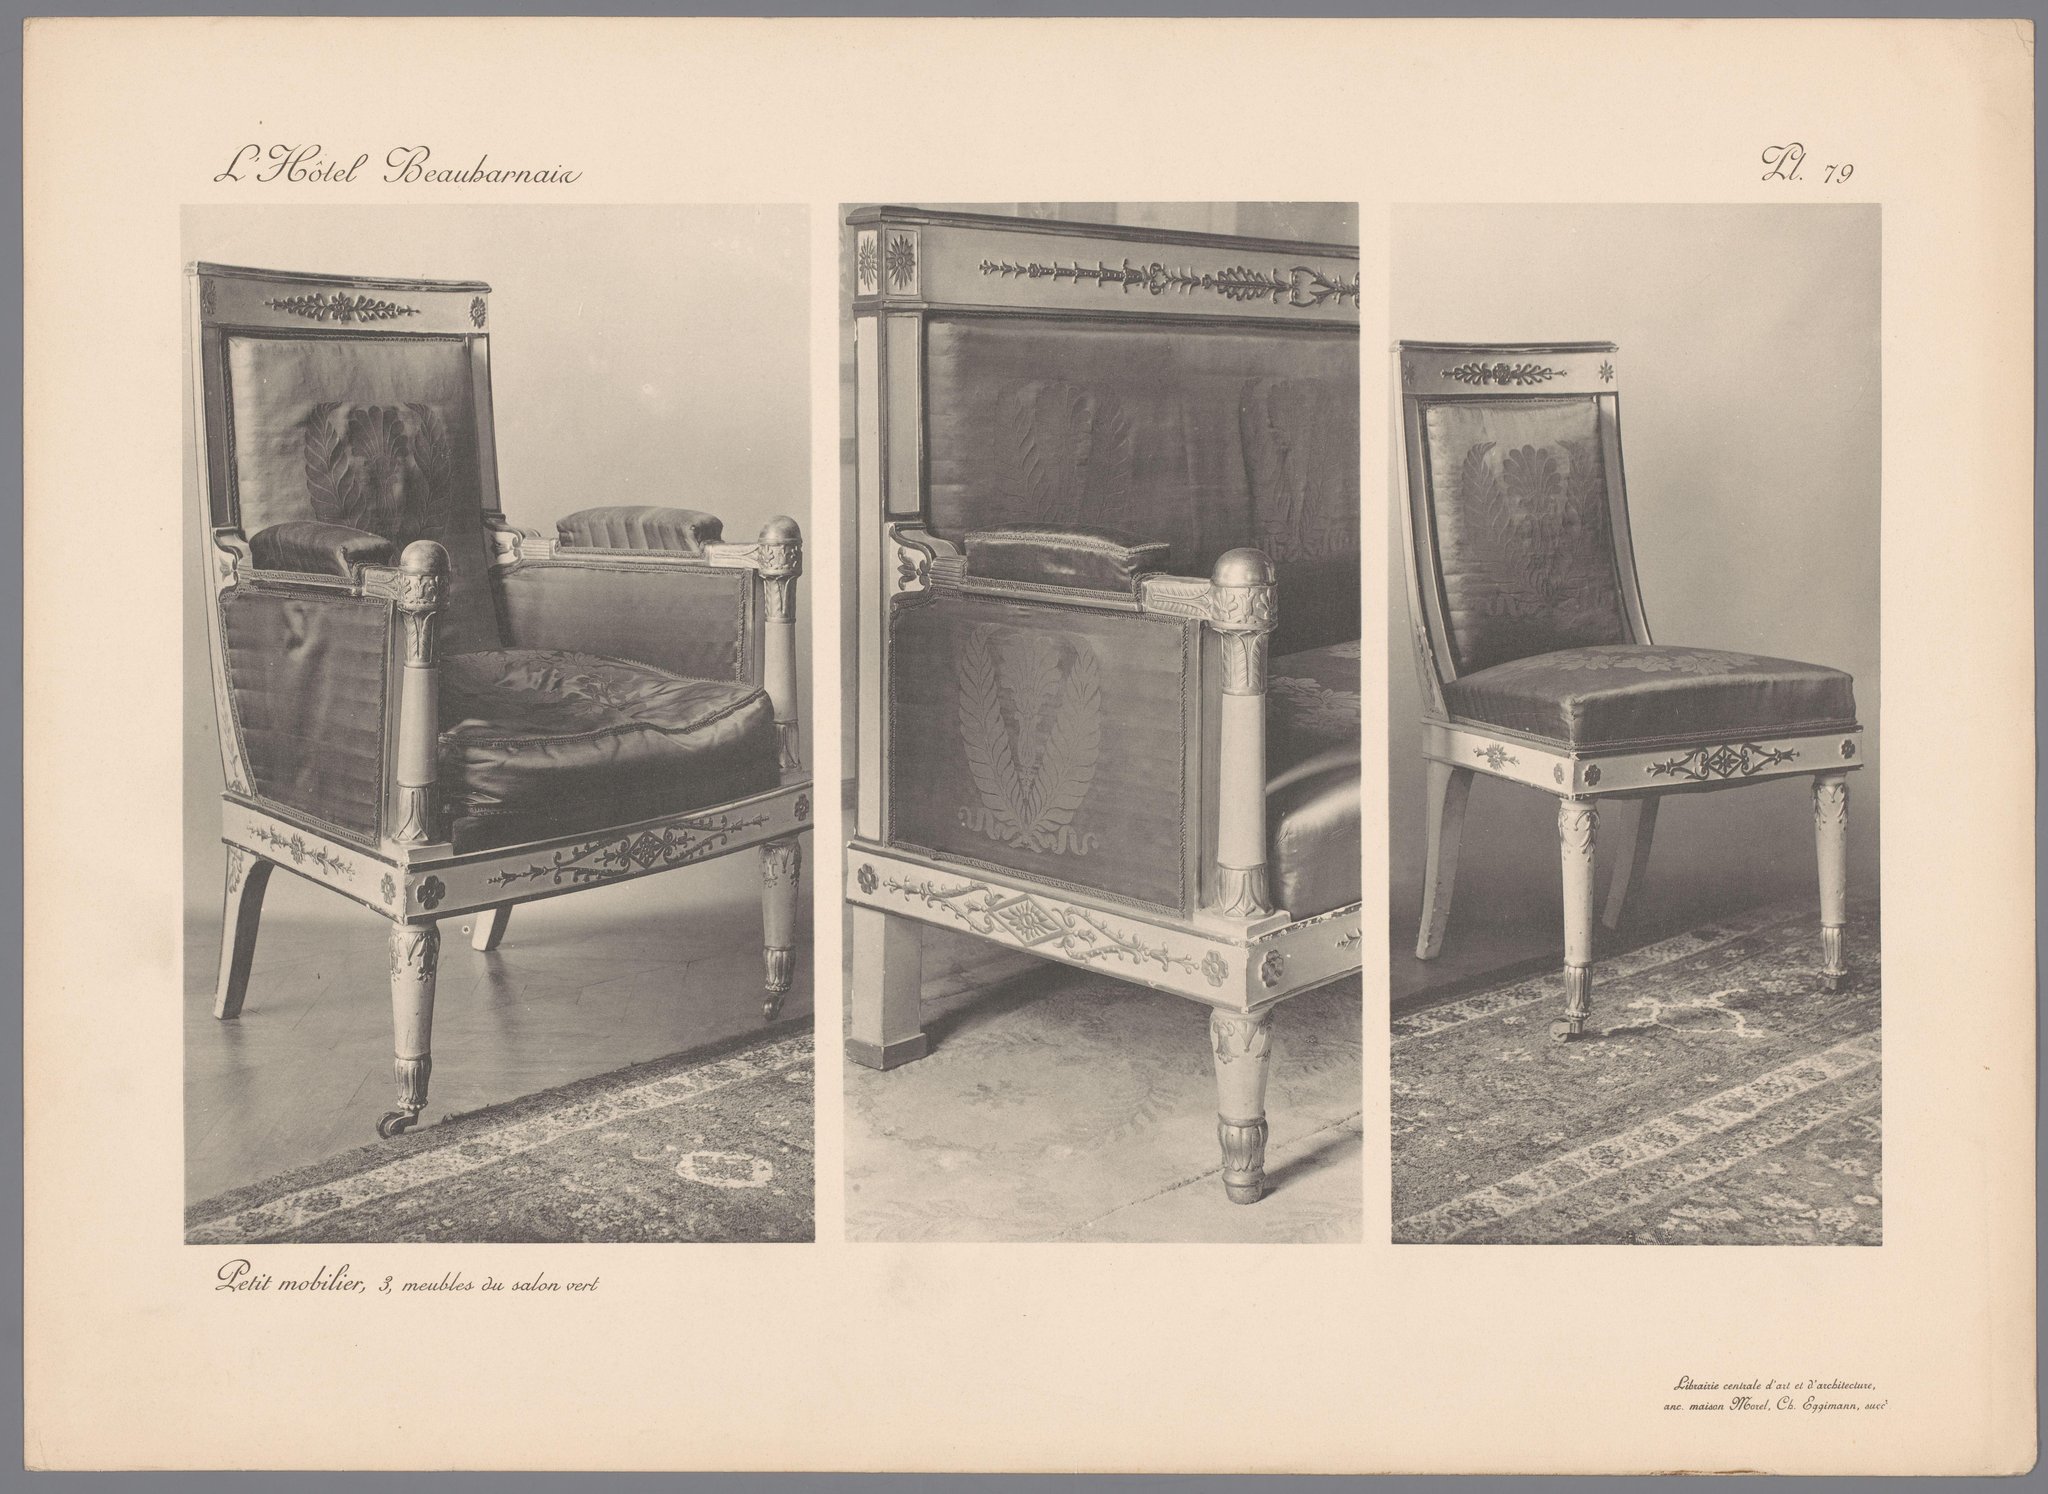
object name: photomechanical print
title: Petit Mobilier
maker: Anonymous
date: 1875-1930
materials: paper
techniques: photograph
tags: armchair, seat, chair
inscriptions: inscription: ‘3, meubles du salon vert’, collector's mark: ‘Rijks normaalschool voor teekenonderwijzers Amsterdam’, number: ‘79’